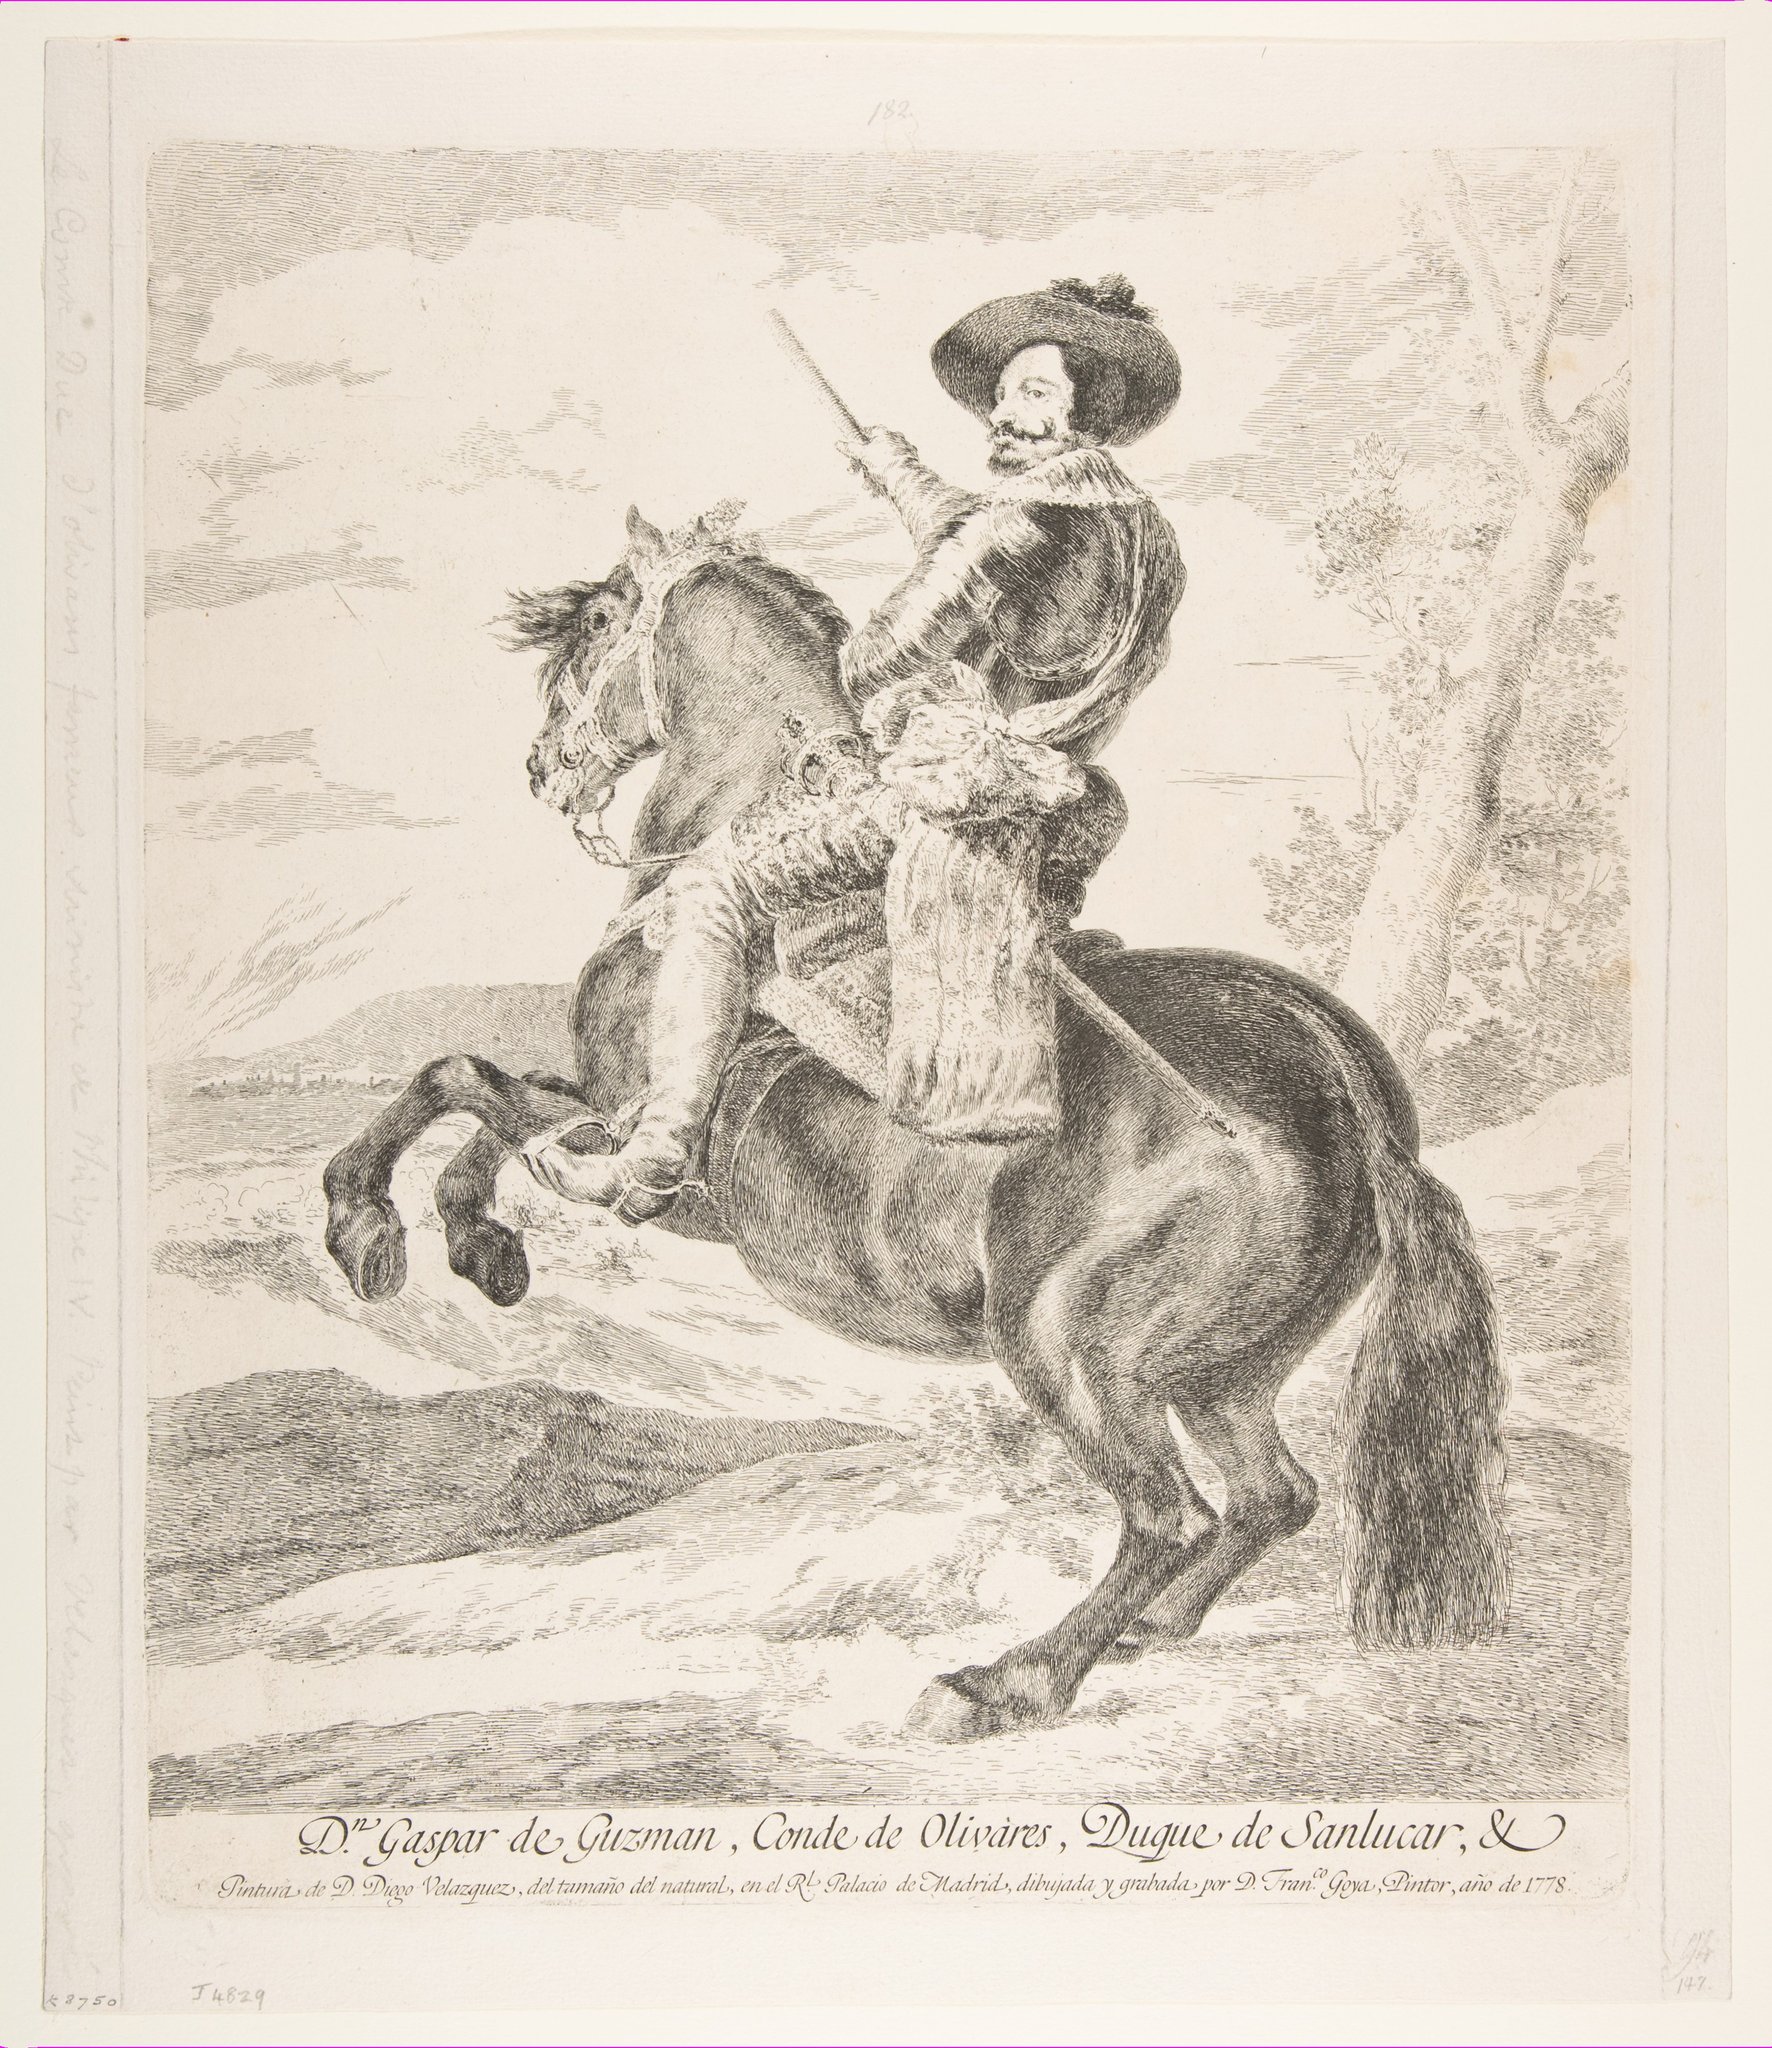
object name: print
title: Gaspar de Guzmán, Count Duke of Olivares on horseback, after Velázquez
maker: goya (francisco de goya y lucientes)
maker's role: artist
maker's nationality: spanish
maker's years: 1746-1828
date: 1778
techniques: etching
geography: spain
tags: swords,men,horses,trees